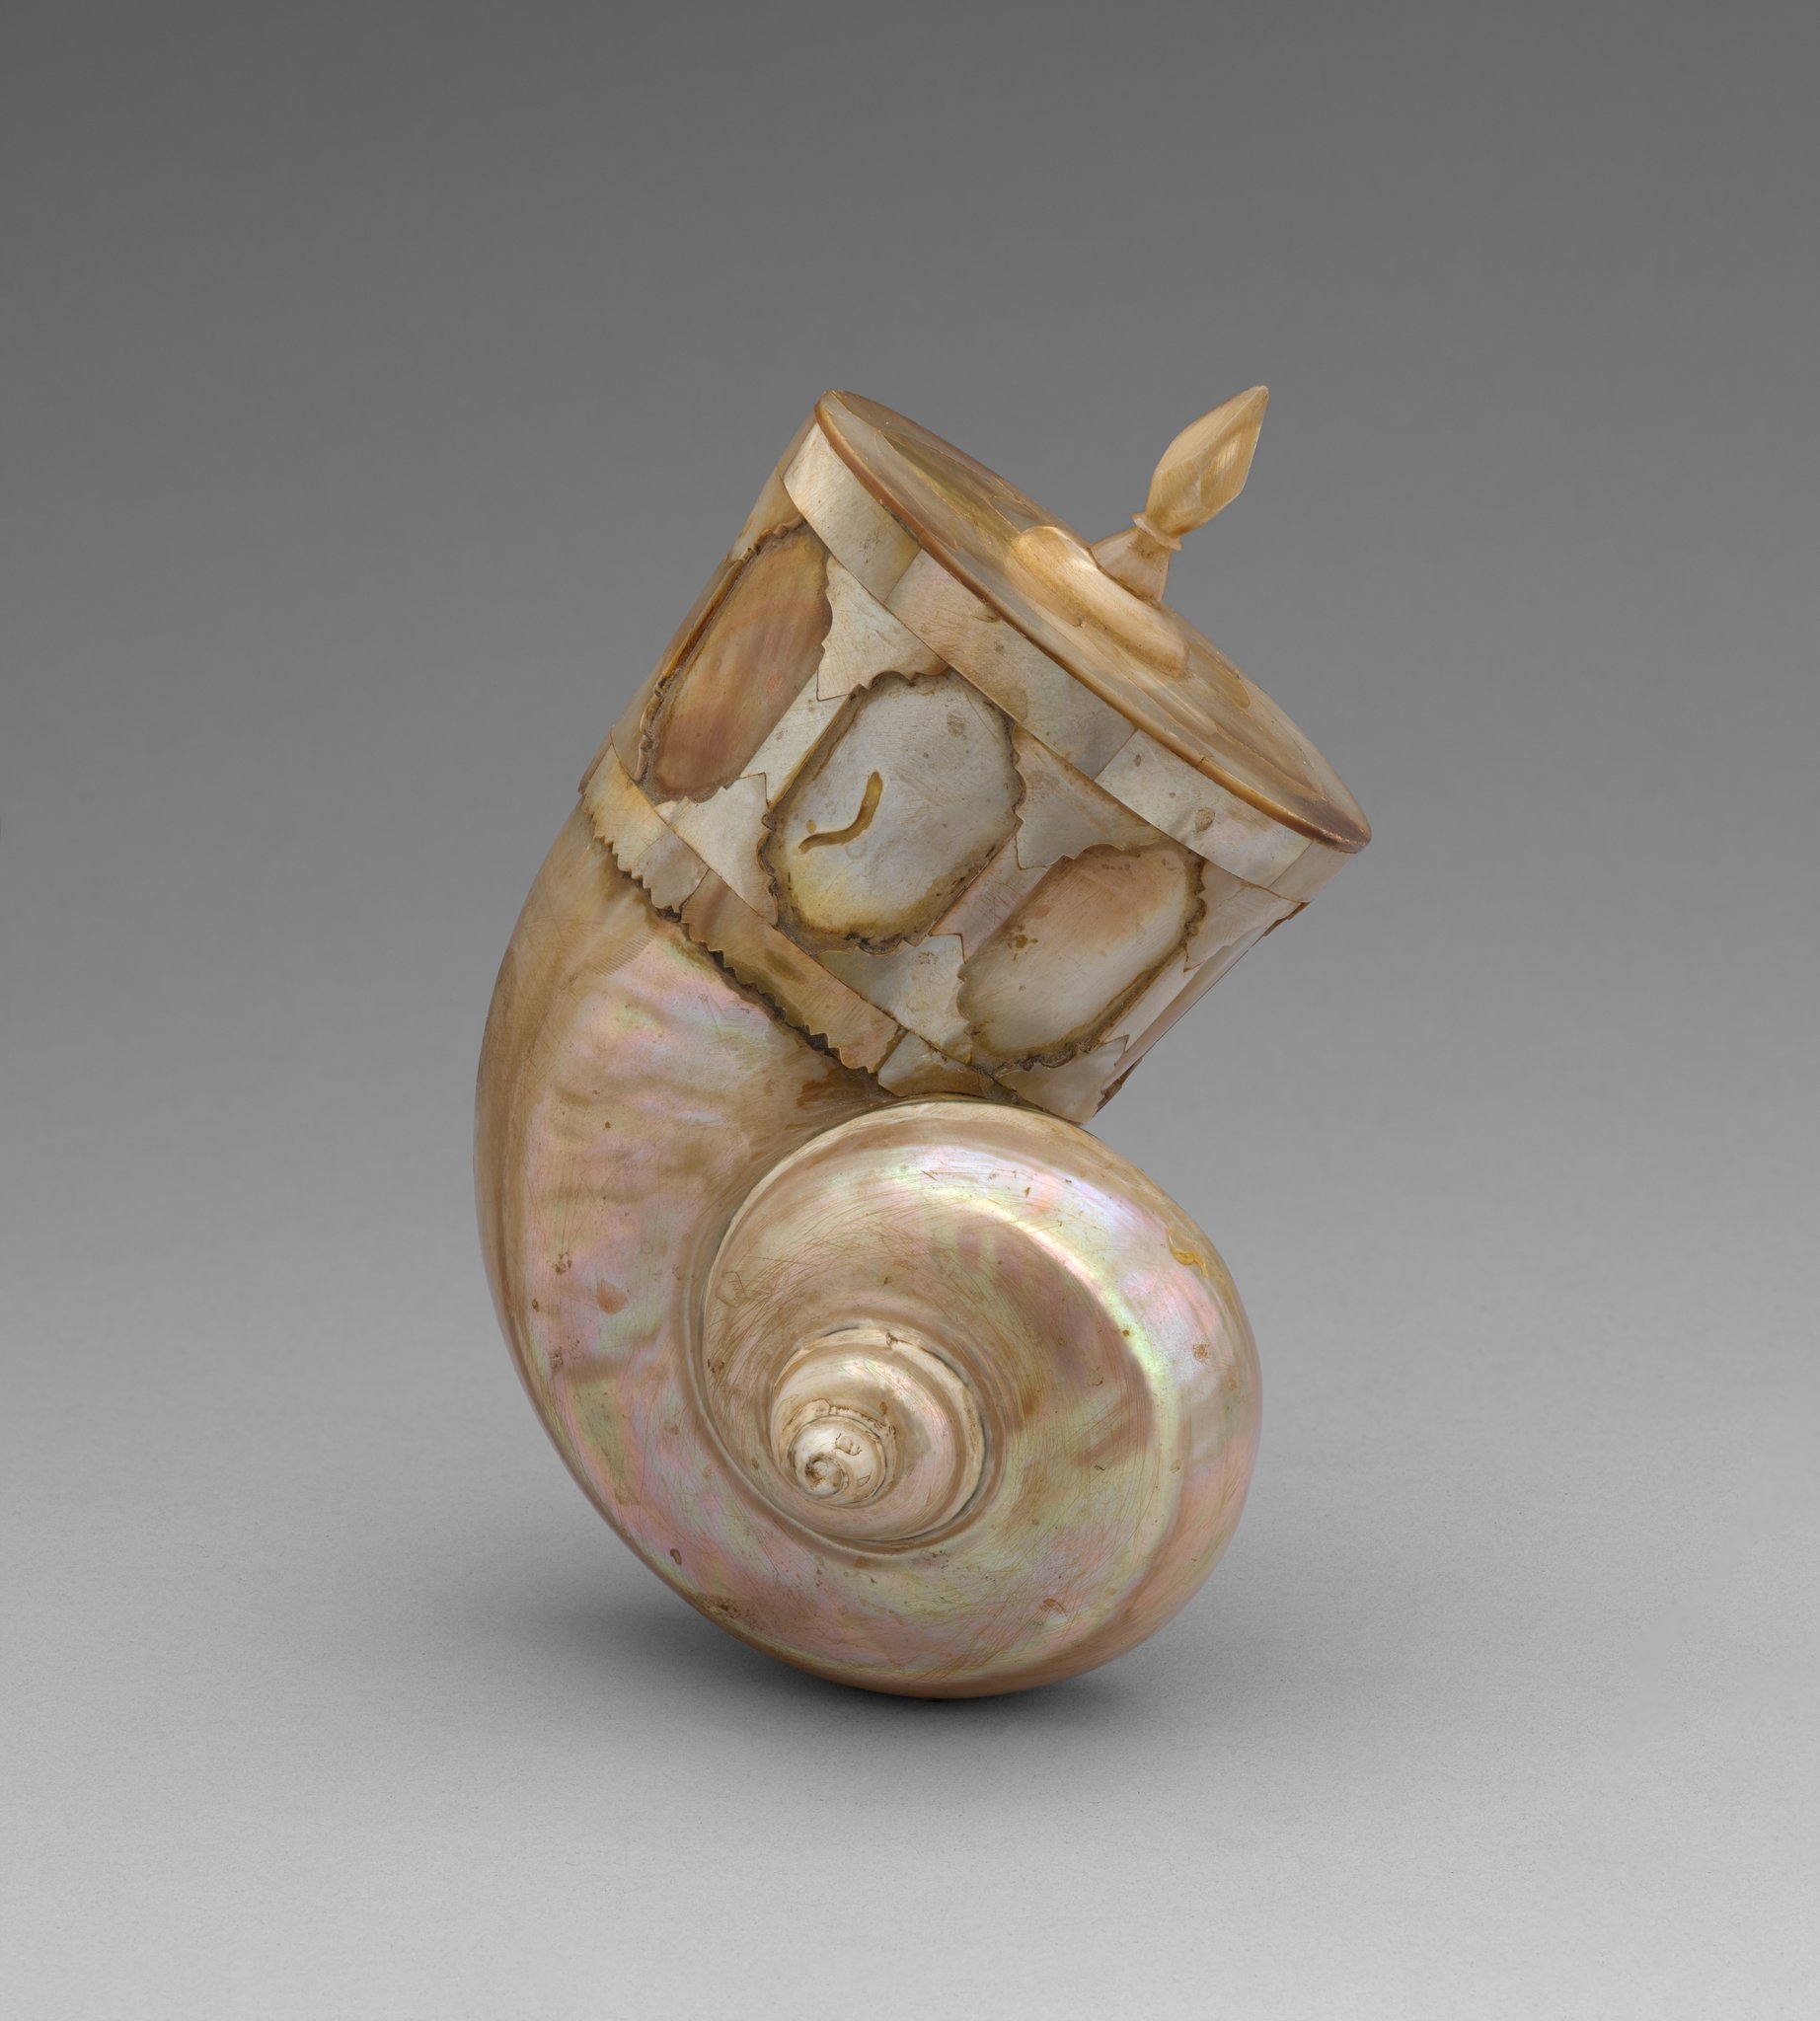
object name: covered container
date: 1701-1900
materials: brass, leather, shell